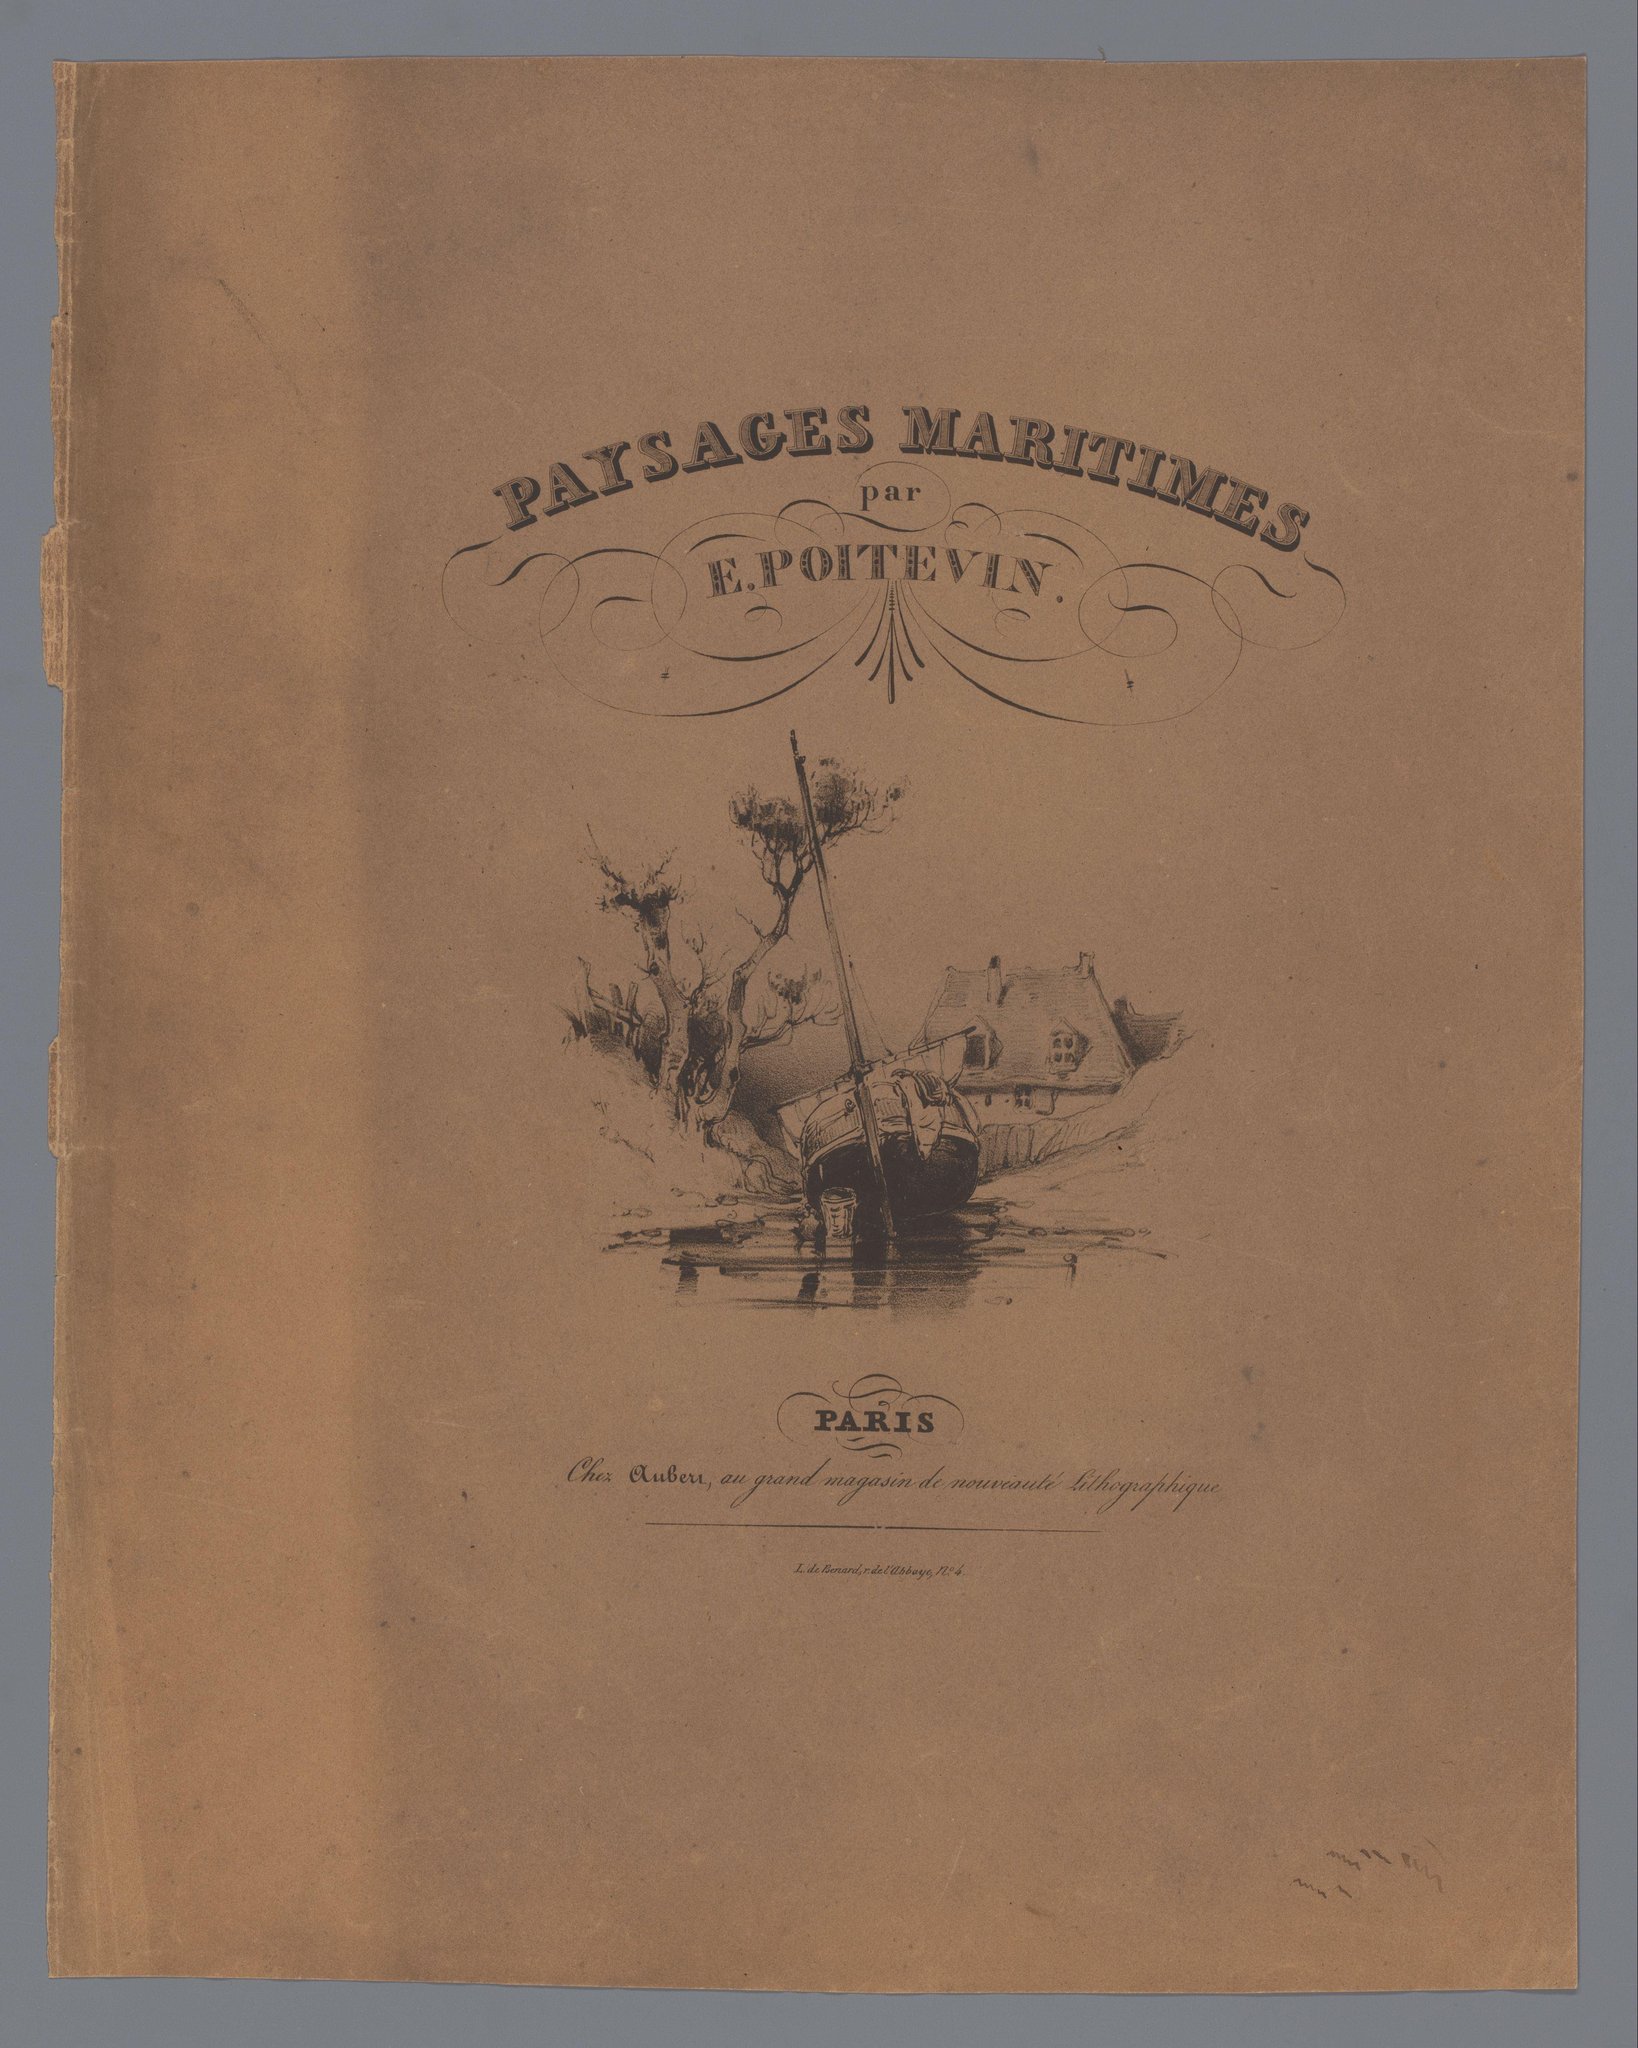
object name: wrapper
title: Omslag voor vijf prenten met gezichten aan de kust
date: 1832-1840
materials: paper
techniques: lithograph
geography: paris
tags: sailing-ship, sailing-boat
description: De achterkant van de omslag is verloren gegaan.